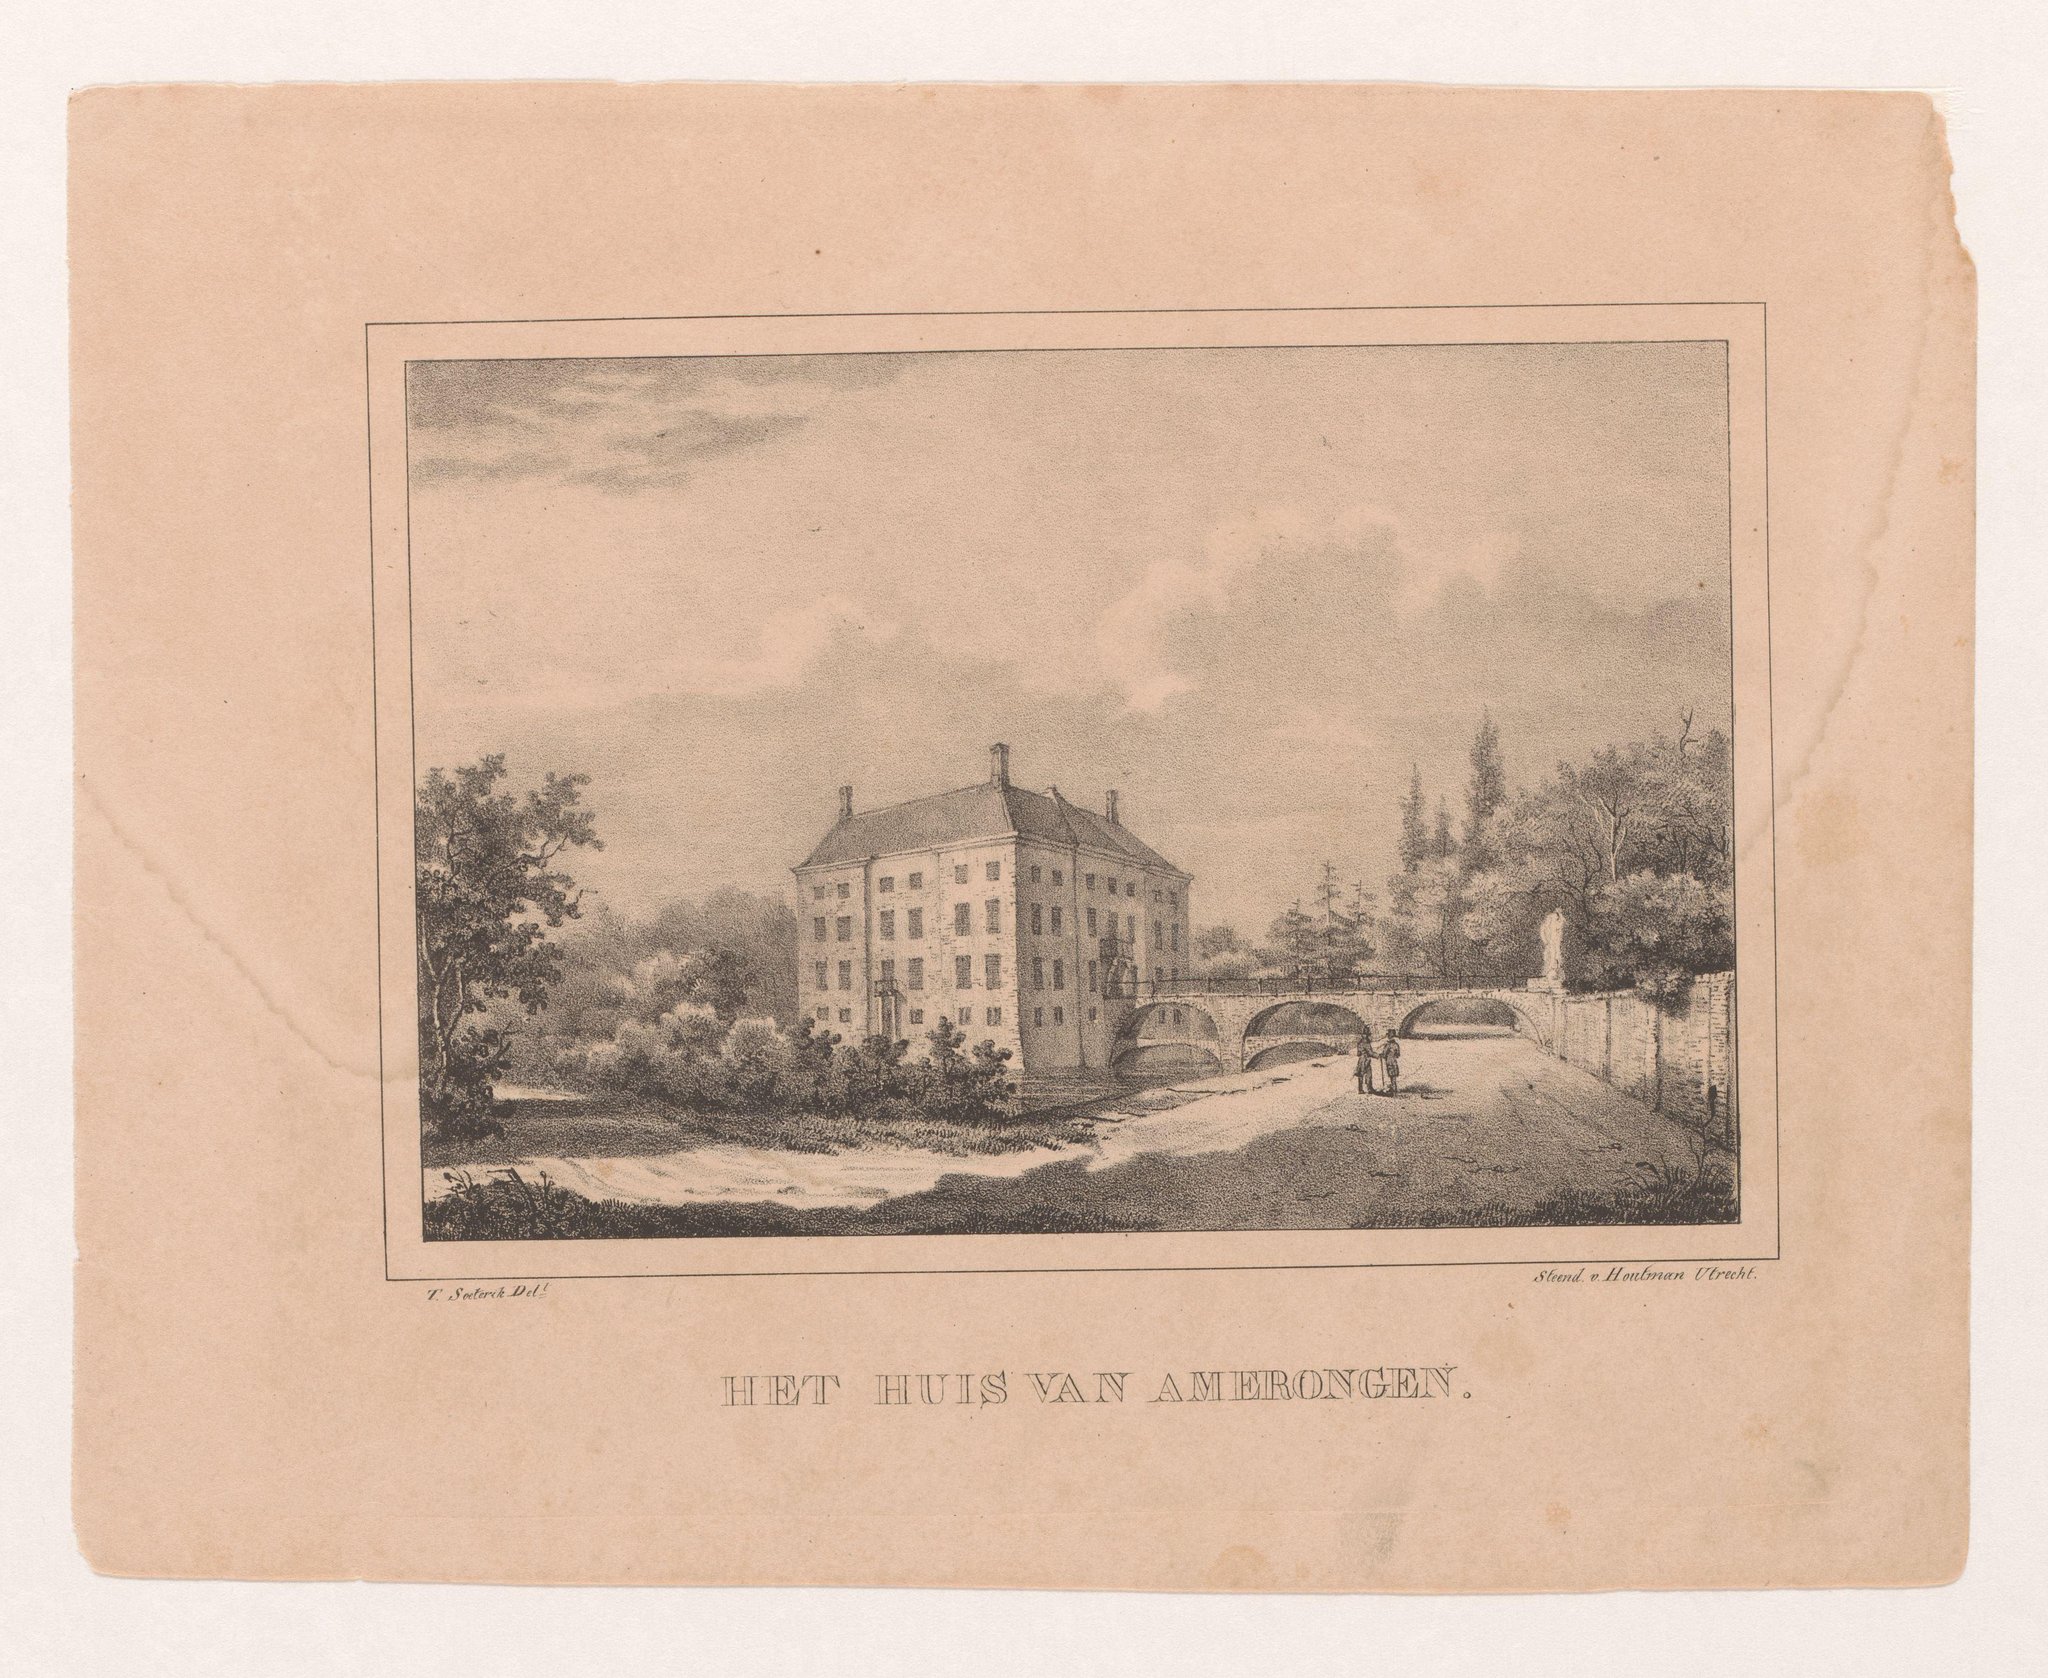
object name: print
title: Kasteel Amerongen te Amerongen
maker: johannes paulus houtman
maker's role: bookseller, print maker, printer, publisher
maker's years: 1803-1845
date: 1828-1830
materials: paper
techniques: lithograph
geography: utrecht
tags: castle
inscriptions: collector's mark: Lugt 2228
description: Prent uit: Mourot, M. Gezigten van buitenplaatsen en gebouwen gelegen tusschen de stad Utrecht en de Grebbe. Utrecht: Houtman, Johannes Paulus, 1828-1830.